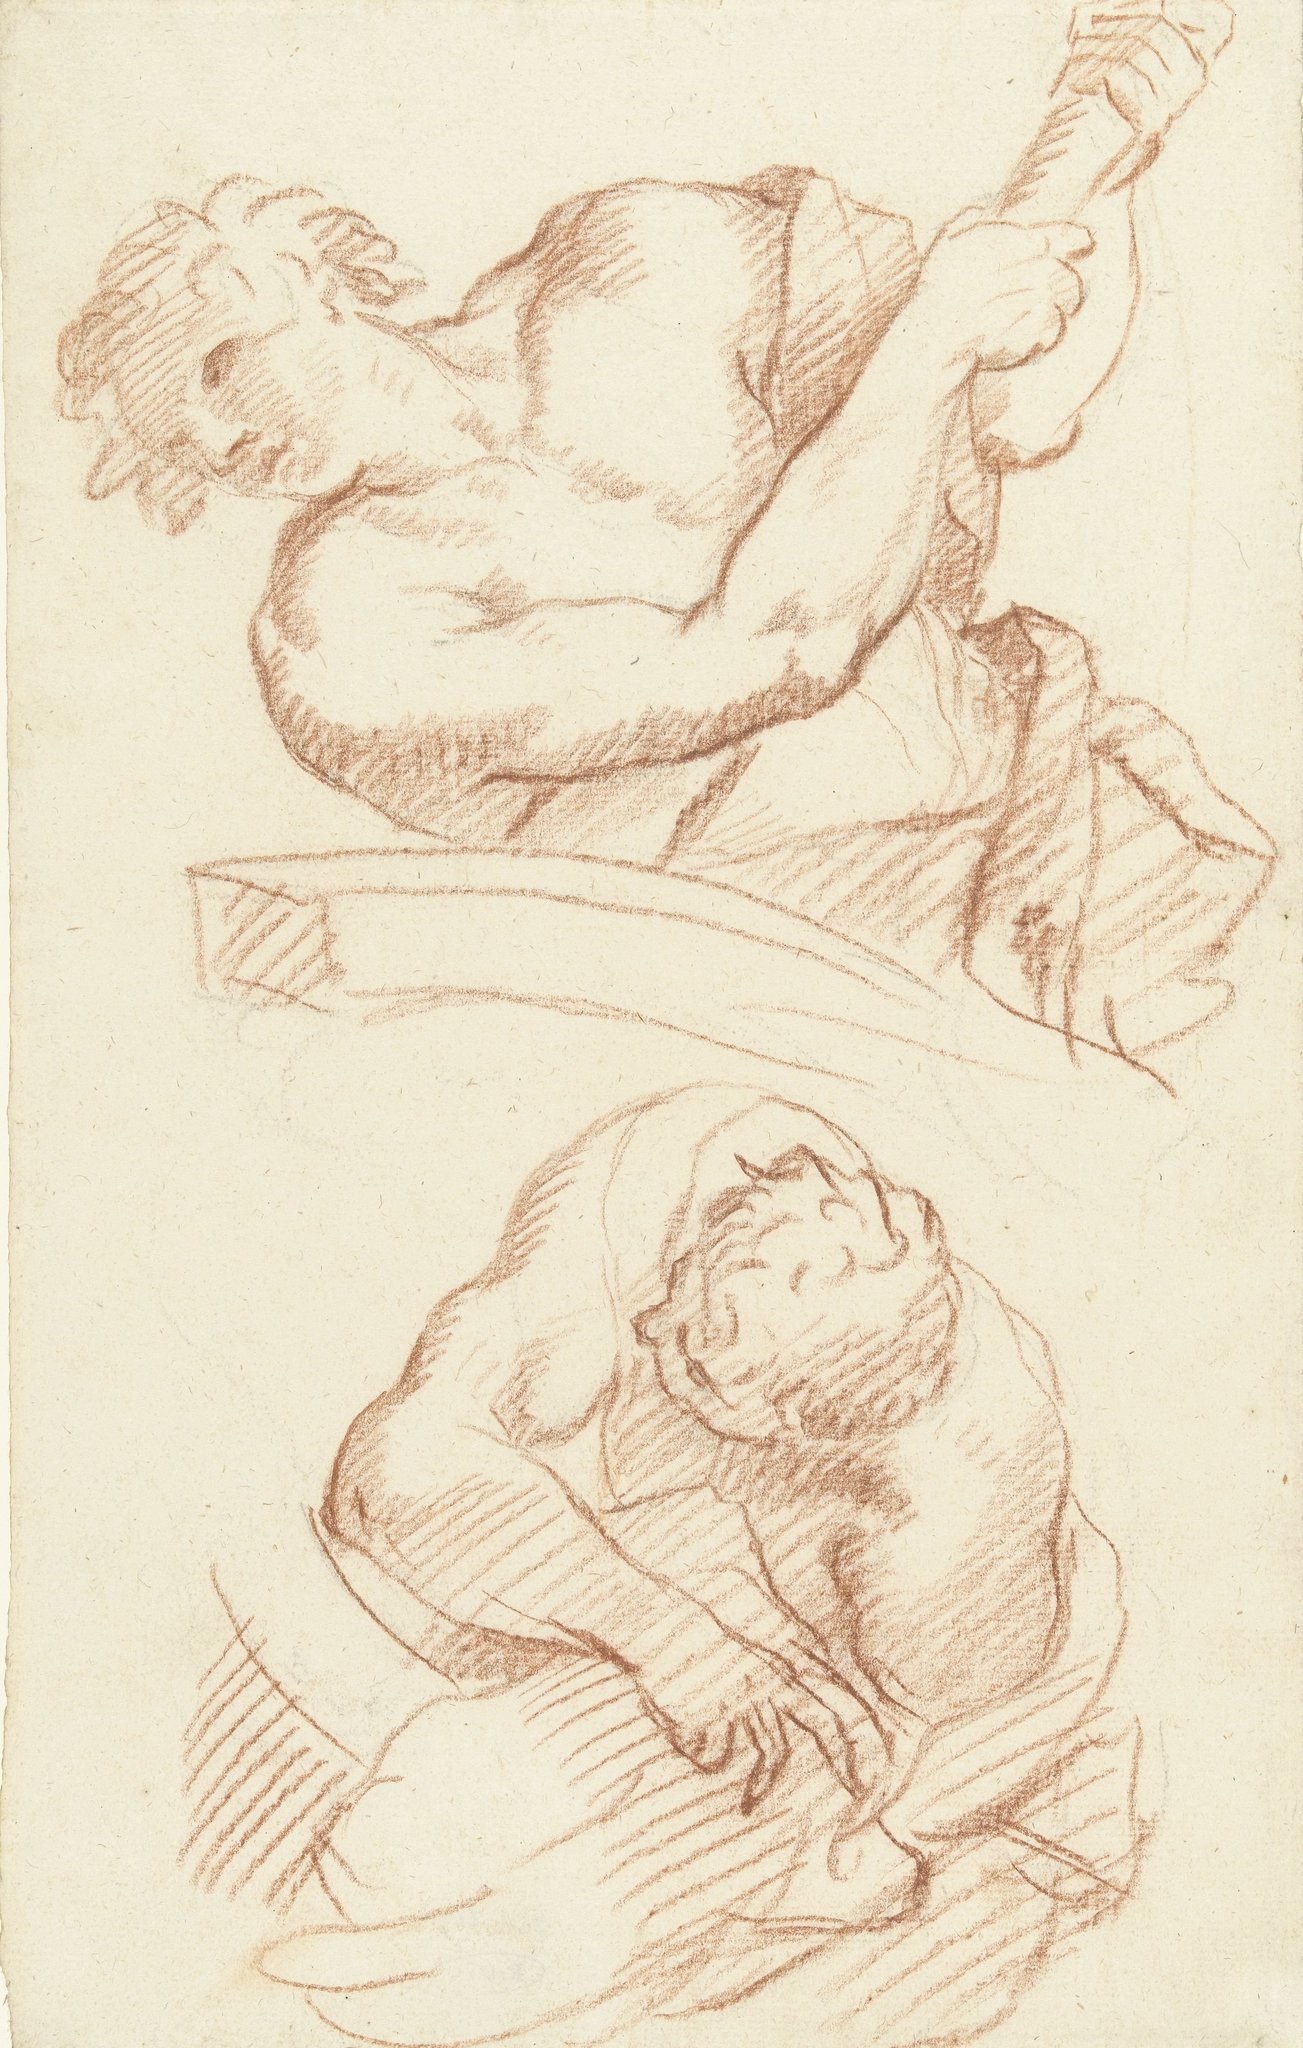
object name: drawing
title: Twee studies van mannen tijdens zwaar werk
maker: dionys van nijmegen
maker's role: draughtsman, painter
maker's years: 1705-1798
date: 1715-1798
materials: chalk, paper